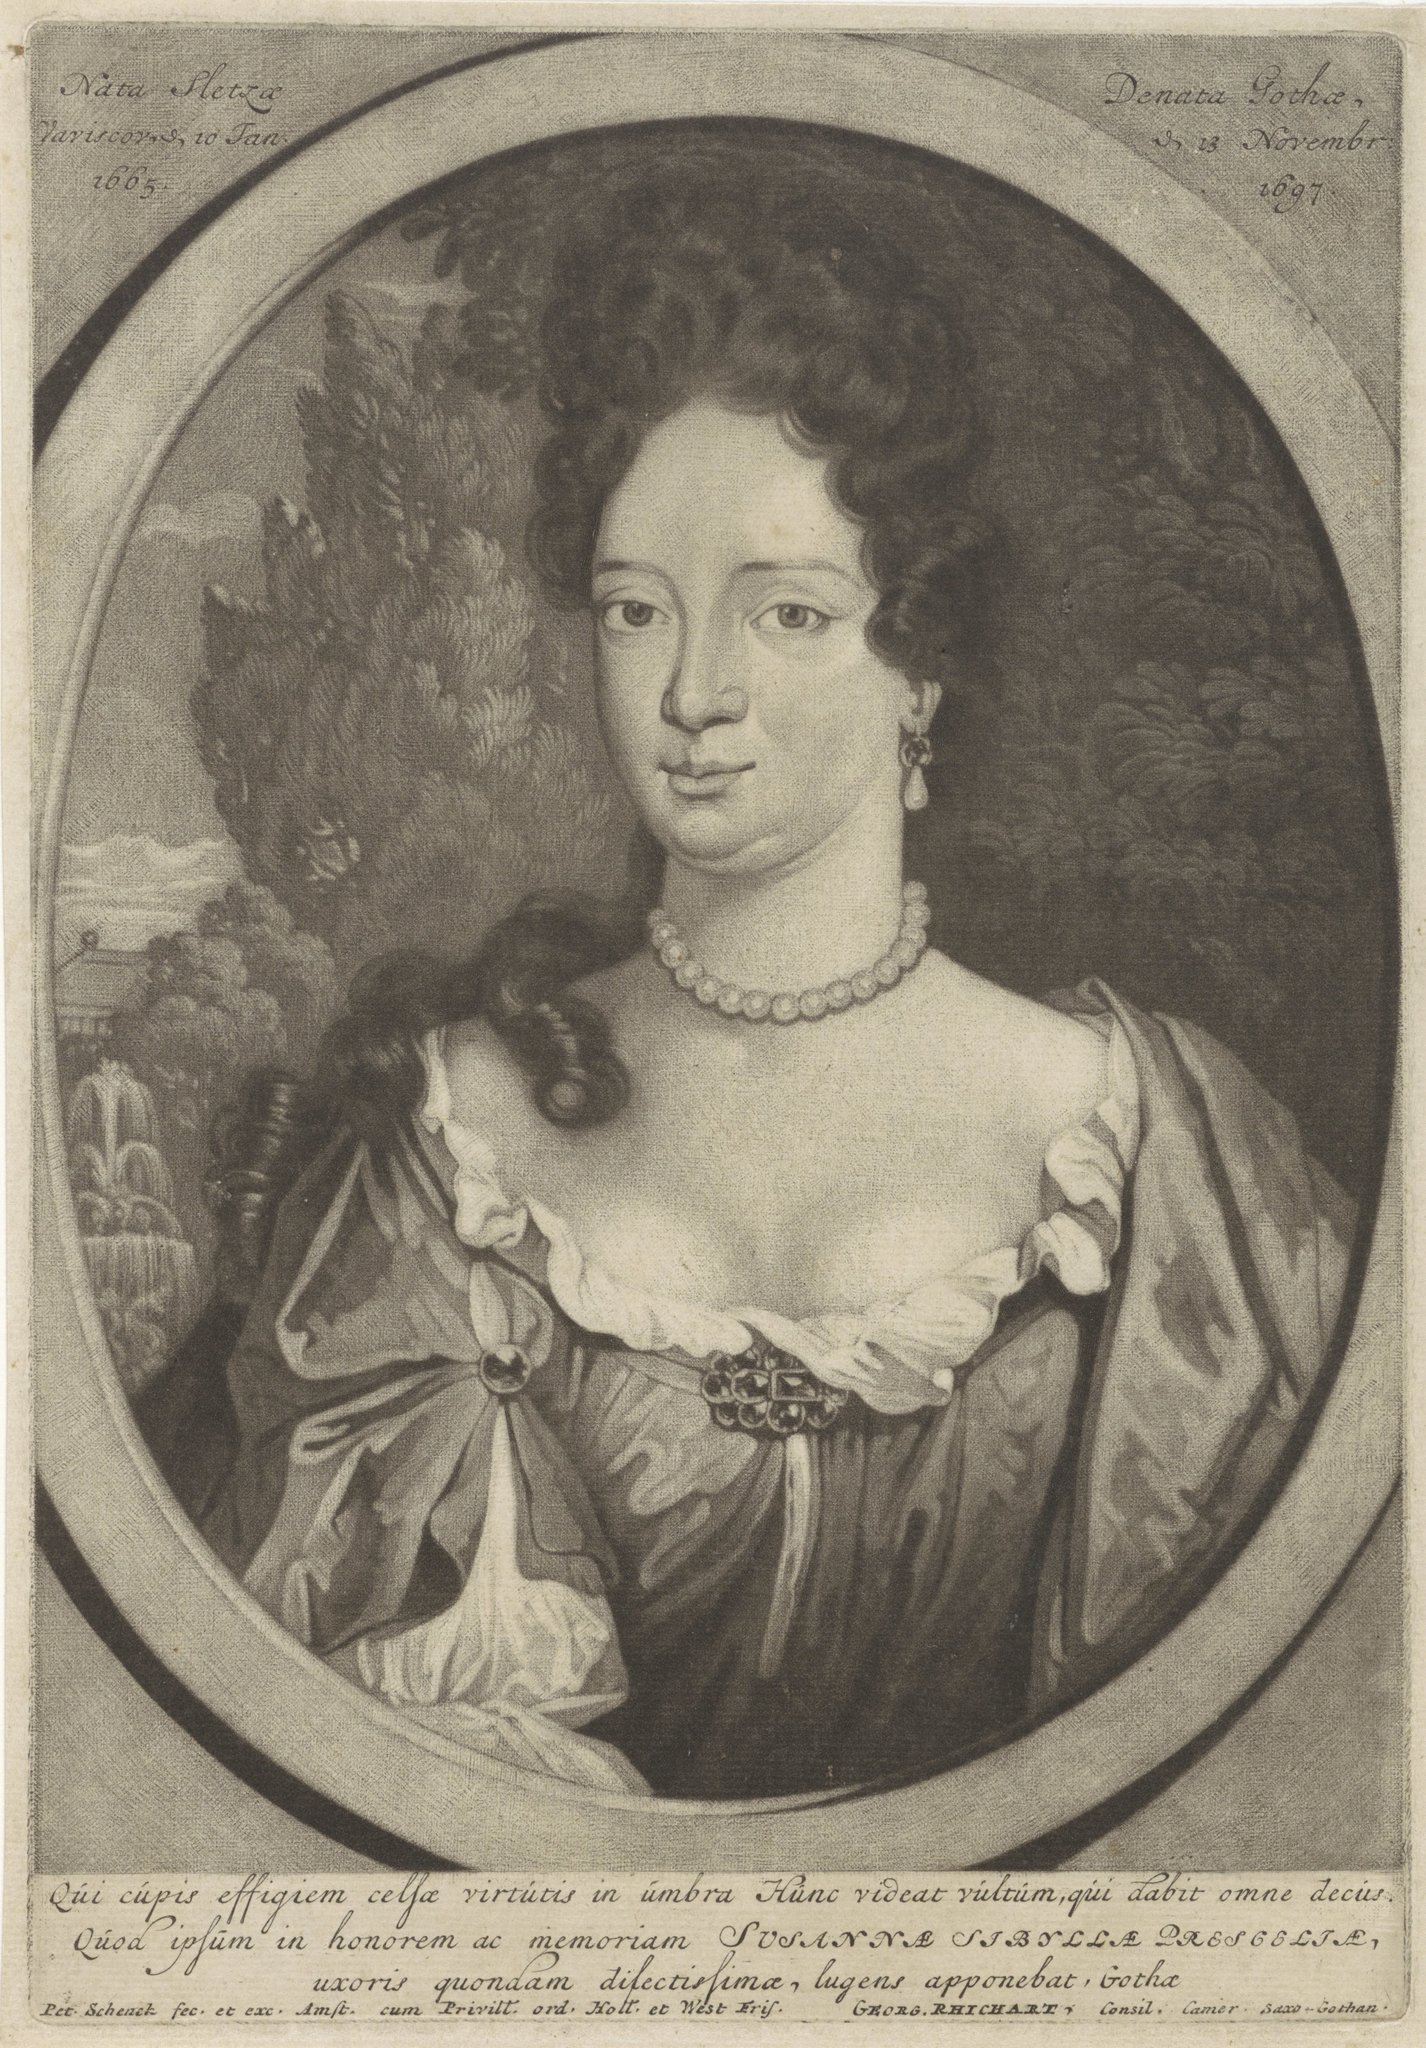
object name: print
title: Portret van Susanna Sibylle Reichardt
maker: pieter schenk (i)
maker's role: print maker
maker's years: 1660-1711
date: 1697-1713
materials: paper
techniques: engraving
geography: amsterdam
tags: garden fountain, pearl; pearl necklace (+ women's clothes)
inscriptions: collector's mark: Lugt 2228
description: Portret van Susanna Sibylla Reichardt (geb. Prescher), echtgenote van Georg Reichardt (kamerheer en rentmeester in Gotha).